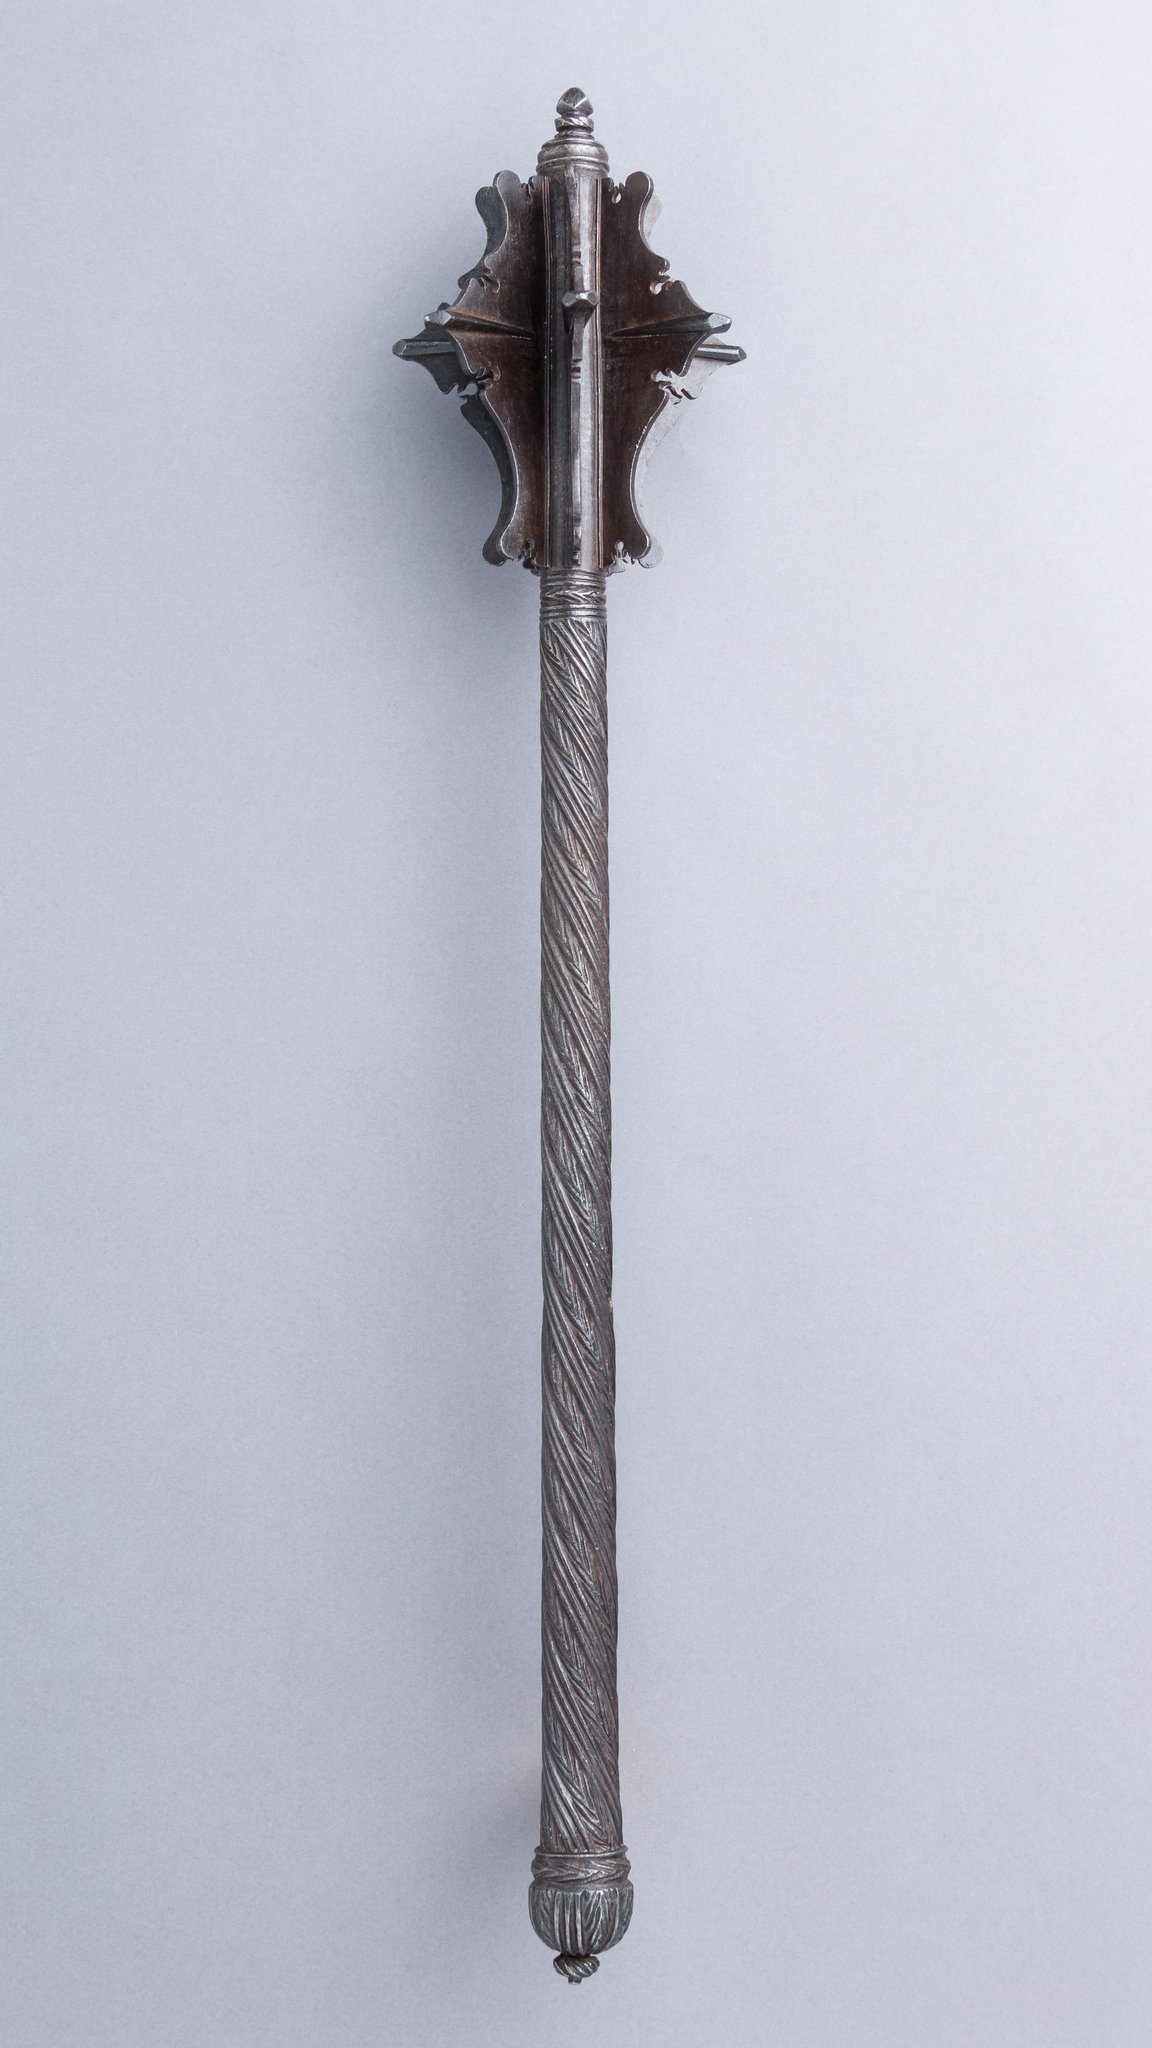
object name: mace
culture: italian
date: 1550-1600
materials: steel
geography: italy